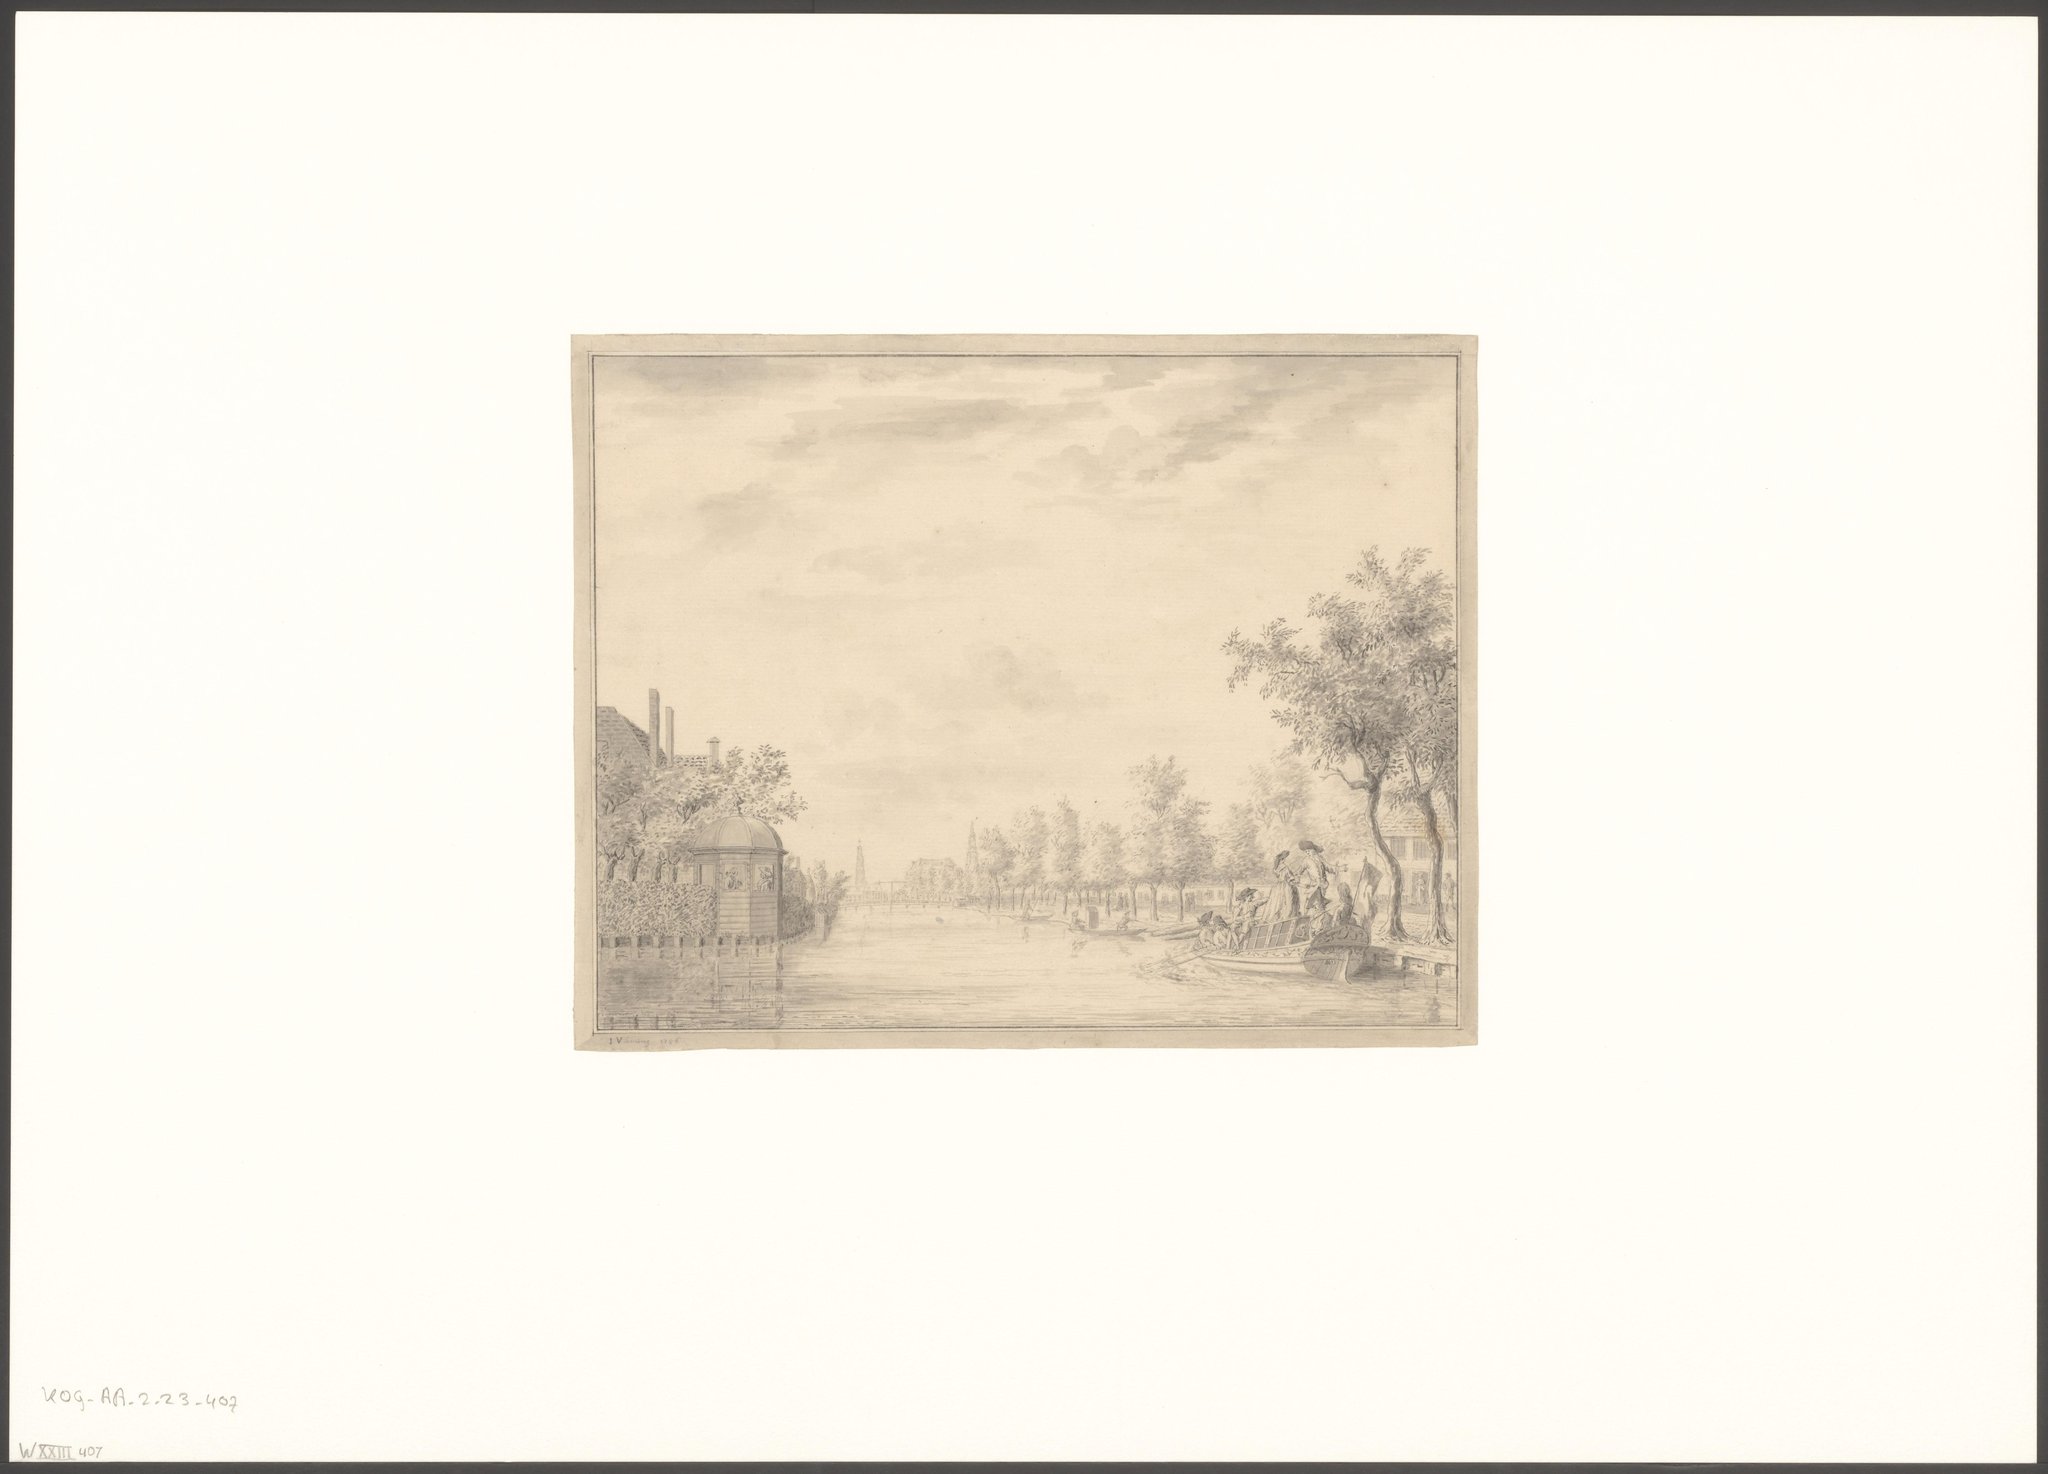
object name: drawing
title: Gezicht op de Plantage Muidergracht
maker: jan de vlaming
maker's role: draughtsman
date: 1756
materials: ink, paper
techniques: brush, pen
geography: amsterdam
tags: city-view in general; 'veduta', canal, bridge in city across river, canal, etc., boat propelled by man or animal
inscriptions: signature and date: ‘I Vlaming 1756’, collector's mark: Lugt 800a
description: Tekening binnen de Atlas Van Eck ingedeeld op wijknummer 23.